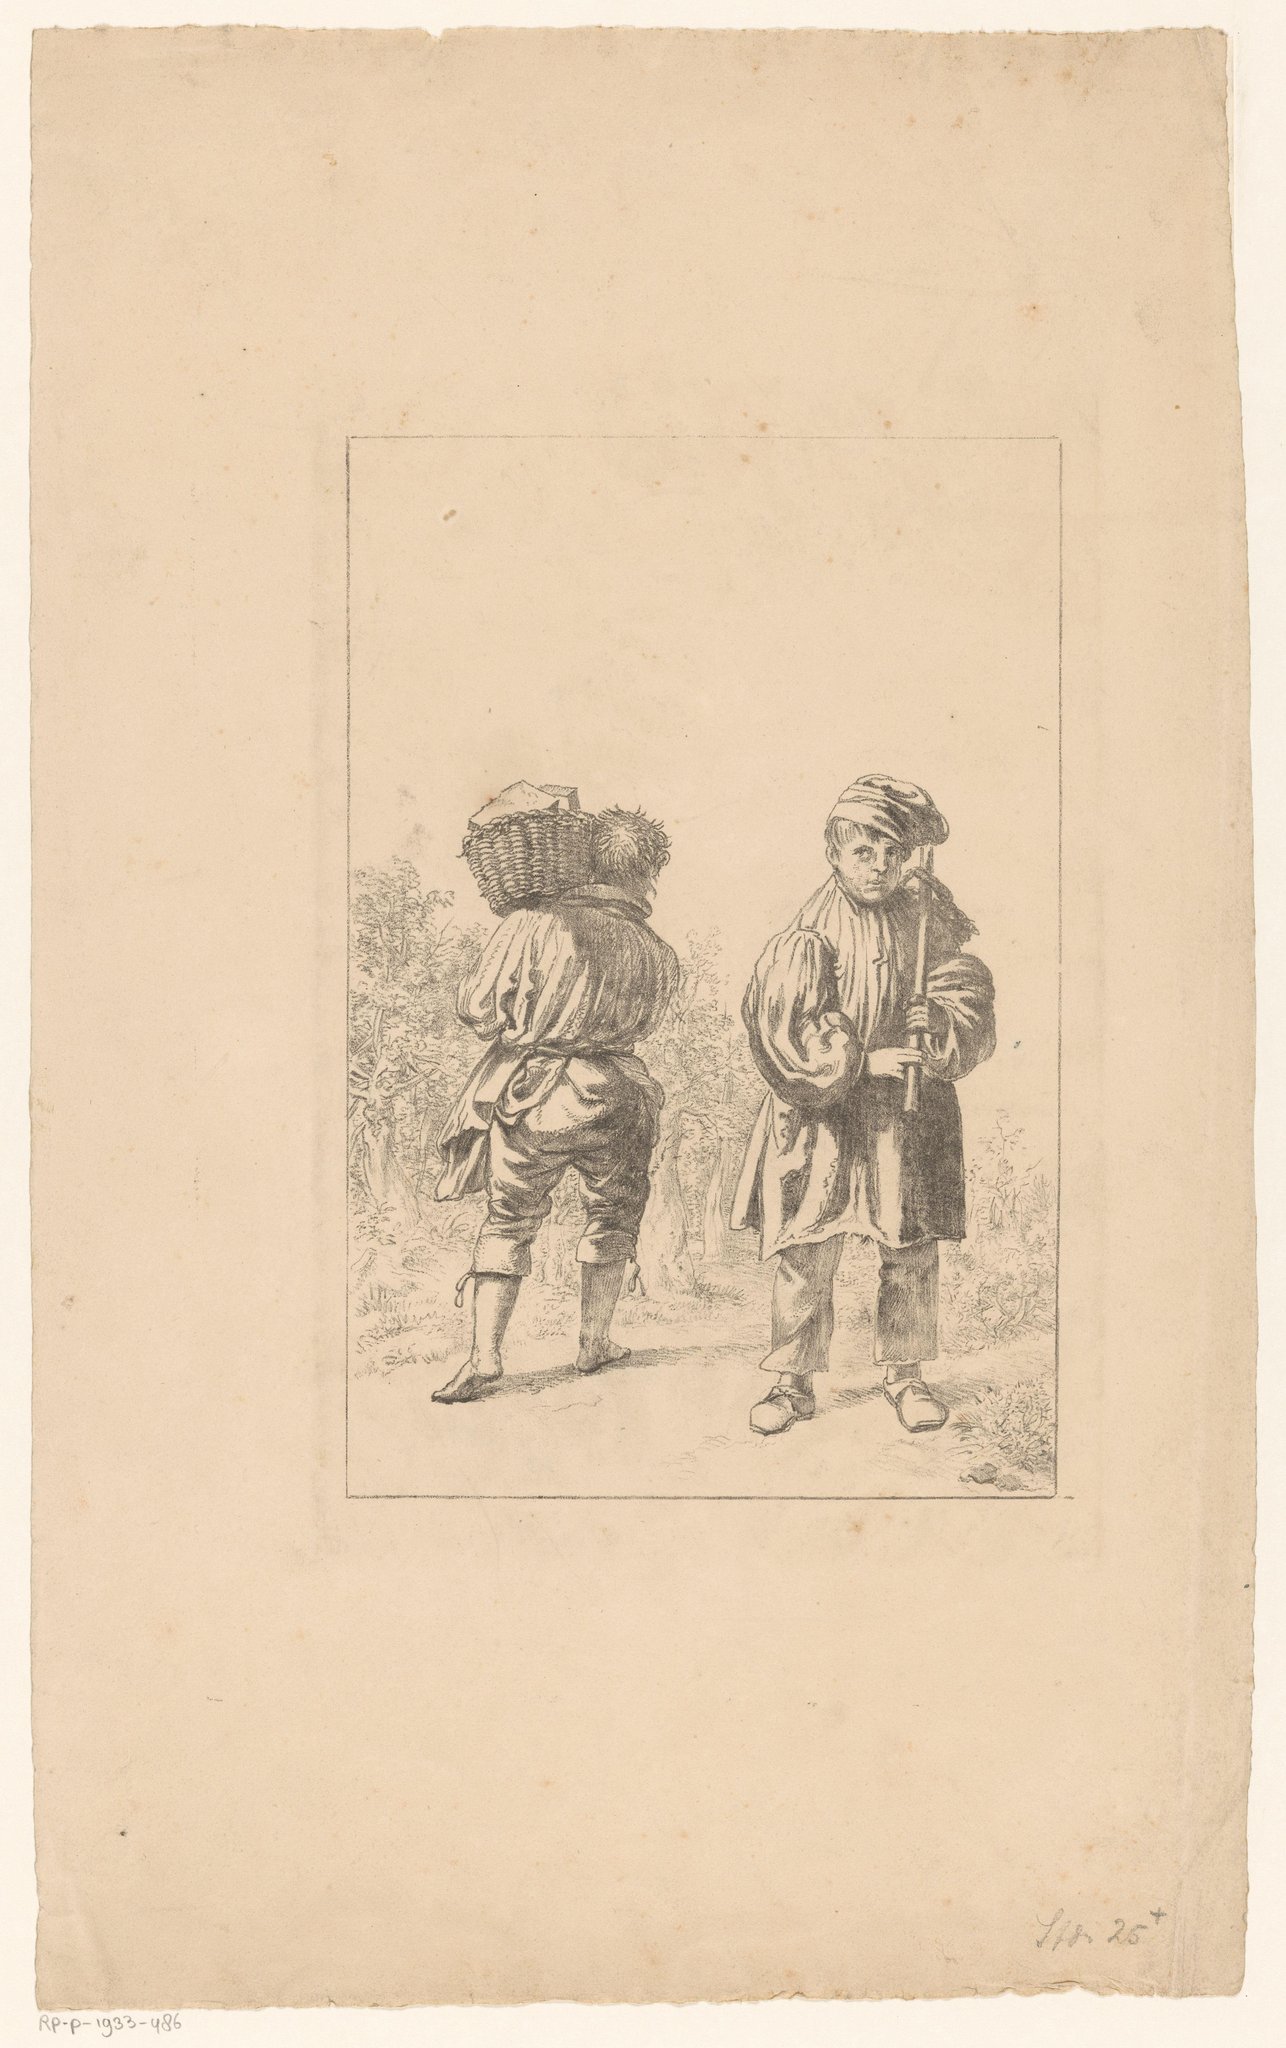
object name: print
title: Twee tuinmannen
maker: Anonymous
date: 1809-1899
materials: paper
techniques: lithograph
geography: netherlands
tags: gardening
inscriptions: collector's mark: Lugt 2228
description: Een man is op de rug gezien, hij draagt een mand op zijn schouder. De figuur rechts van hem draagt een plunjezak aan een stok over zijn schouder.